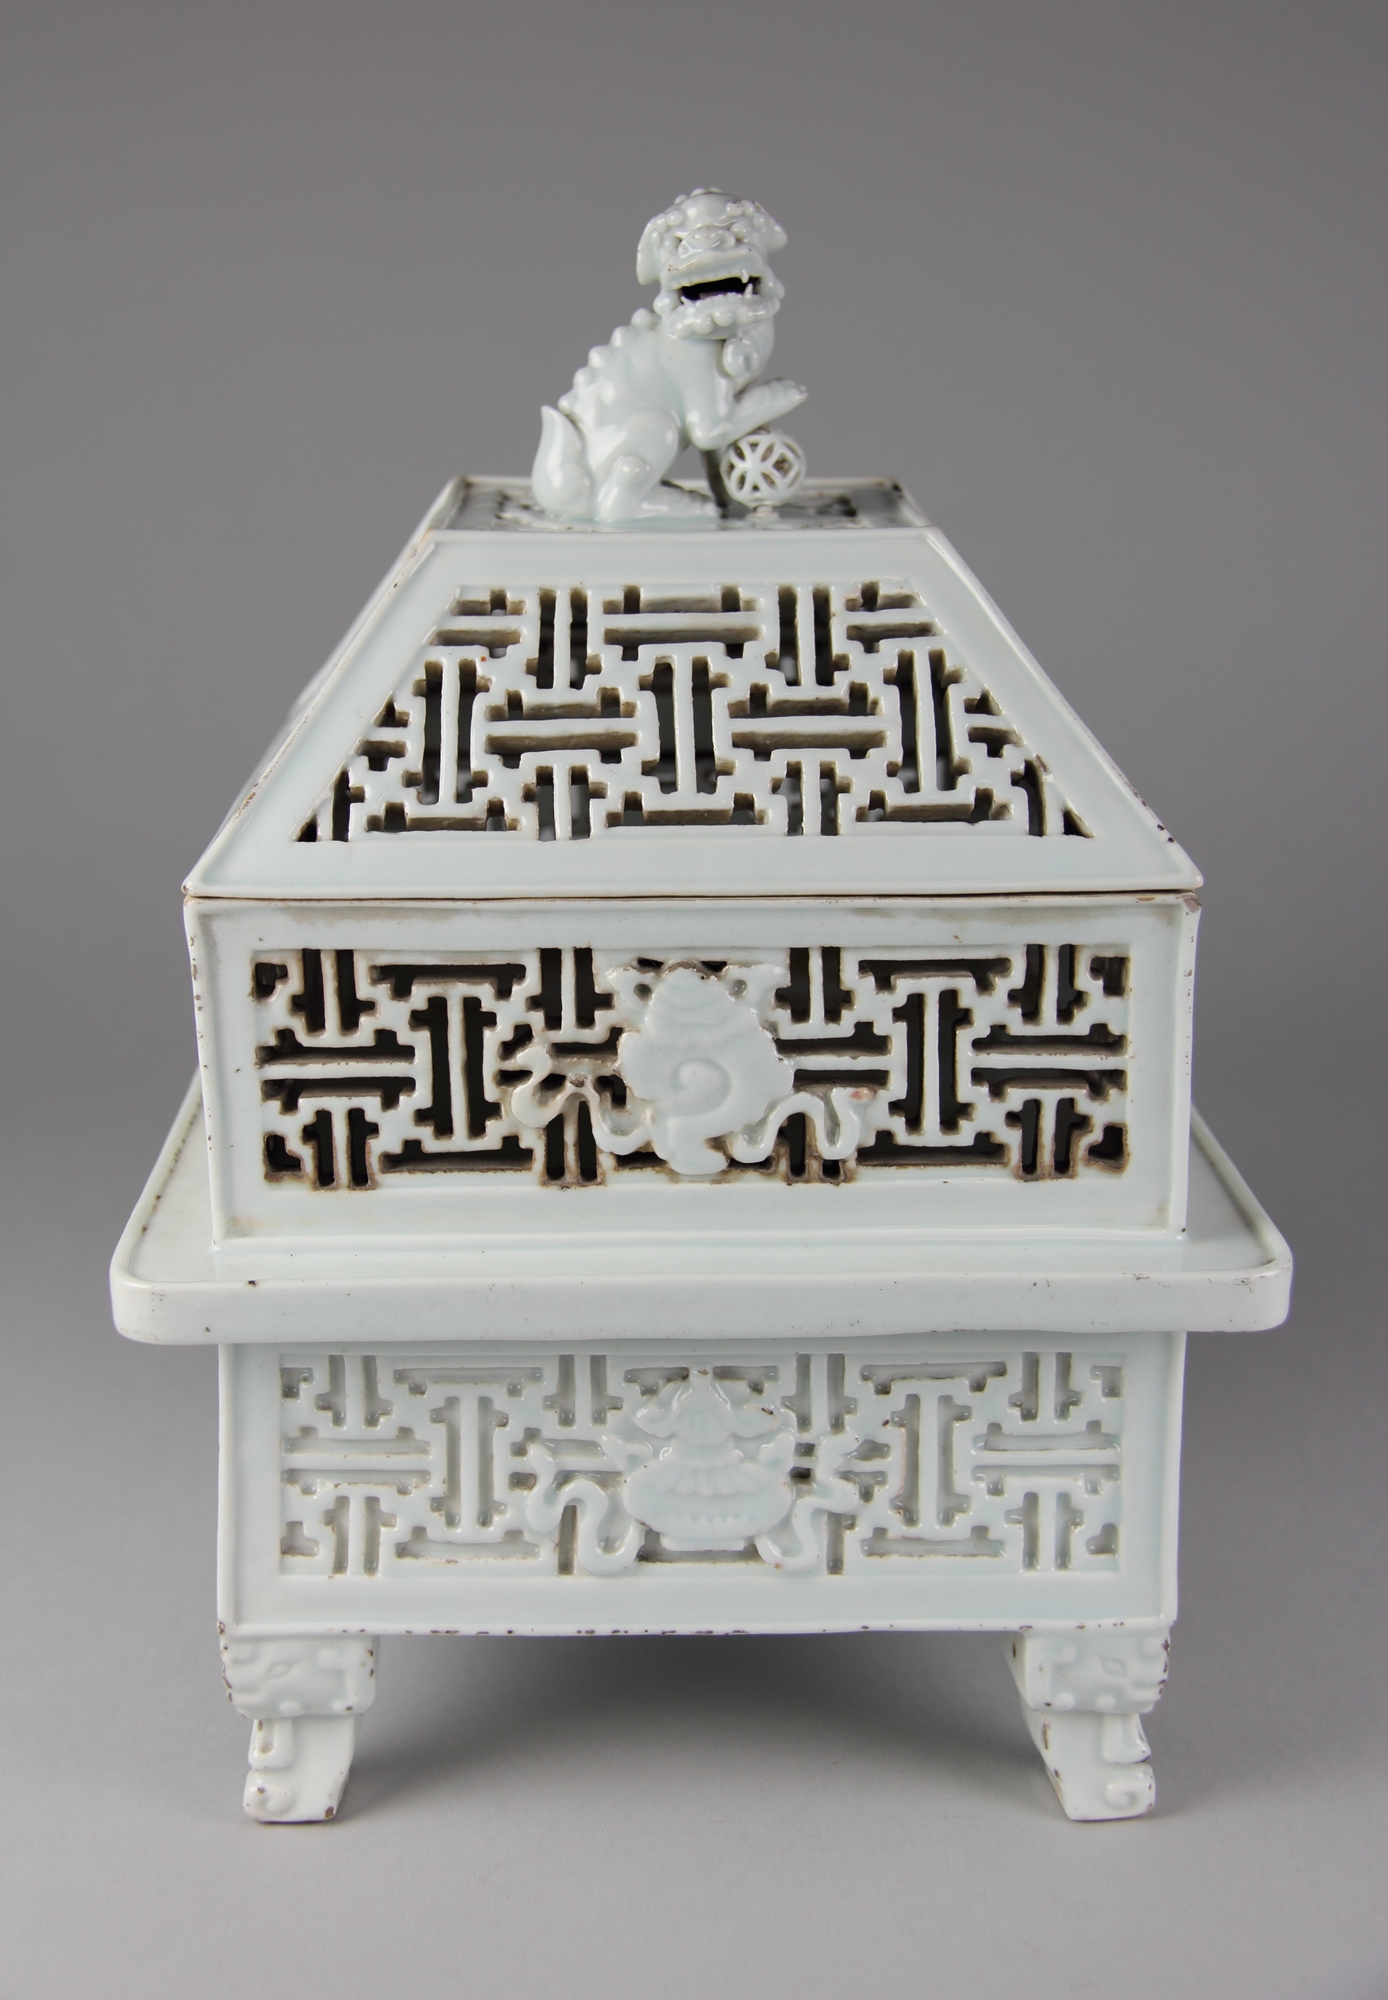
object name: incense burner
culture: chinese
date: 1801-1900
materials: porcelain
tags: animals